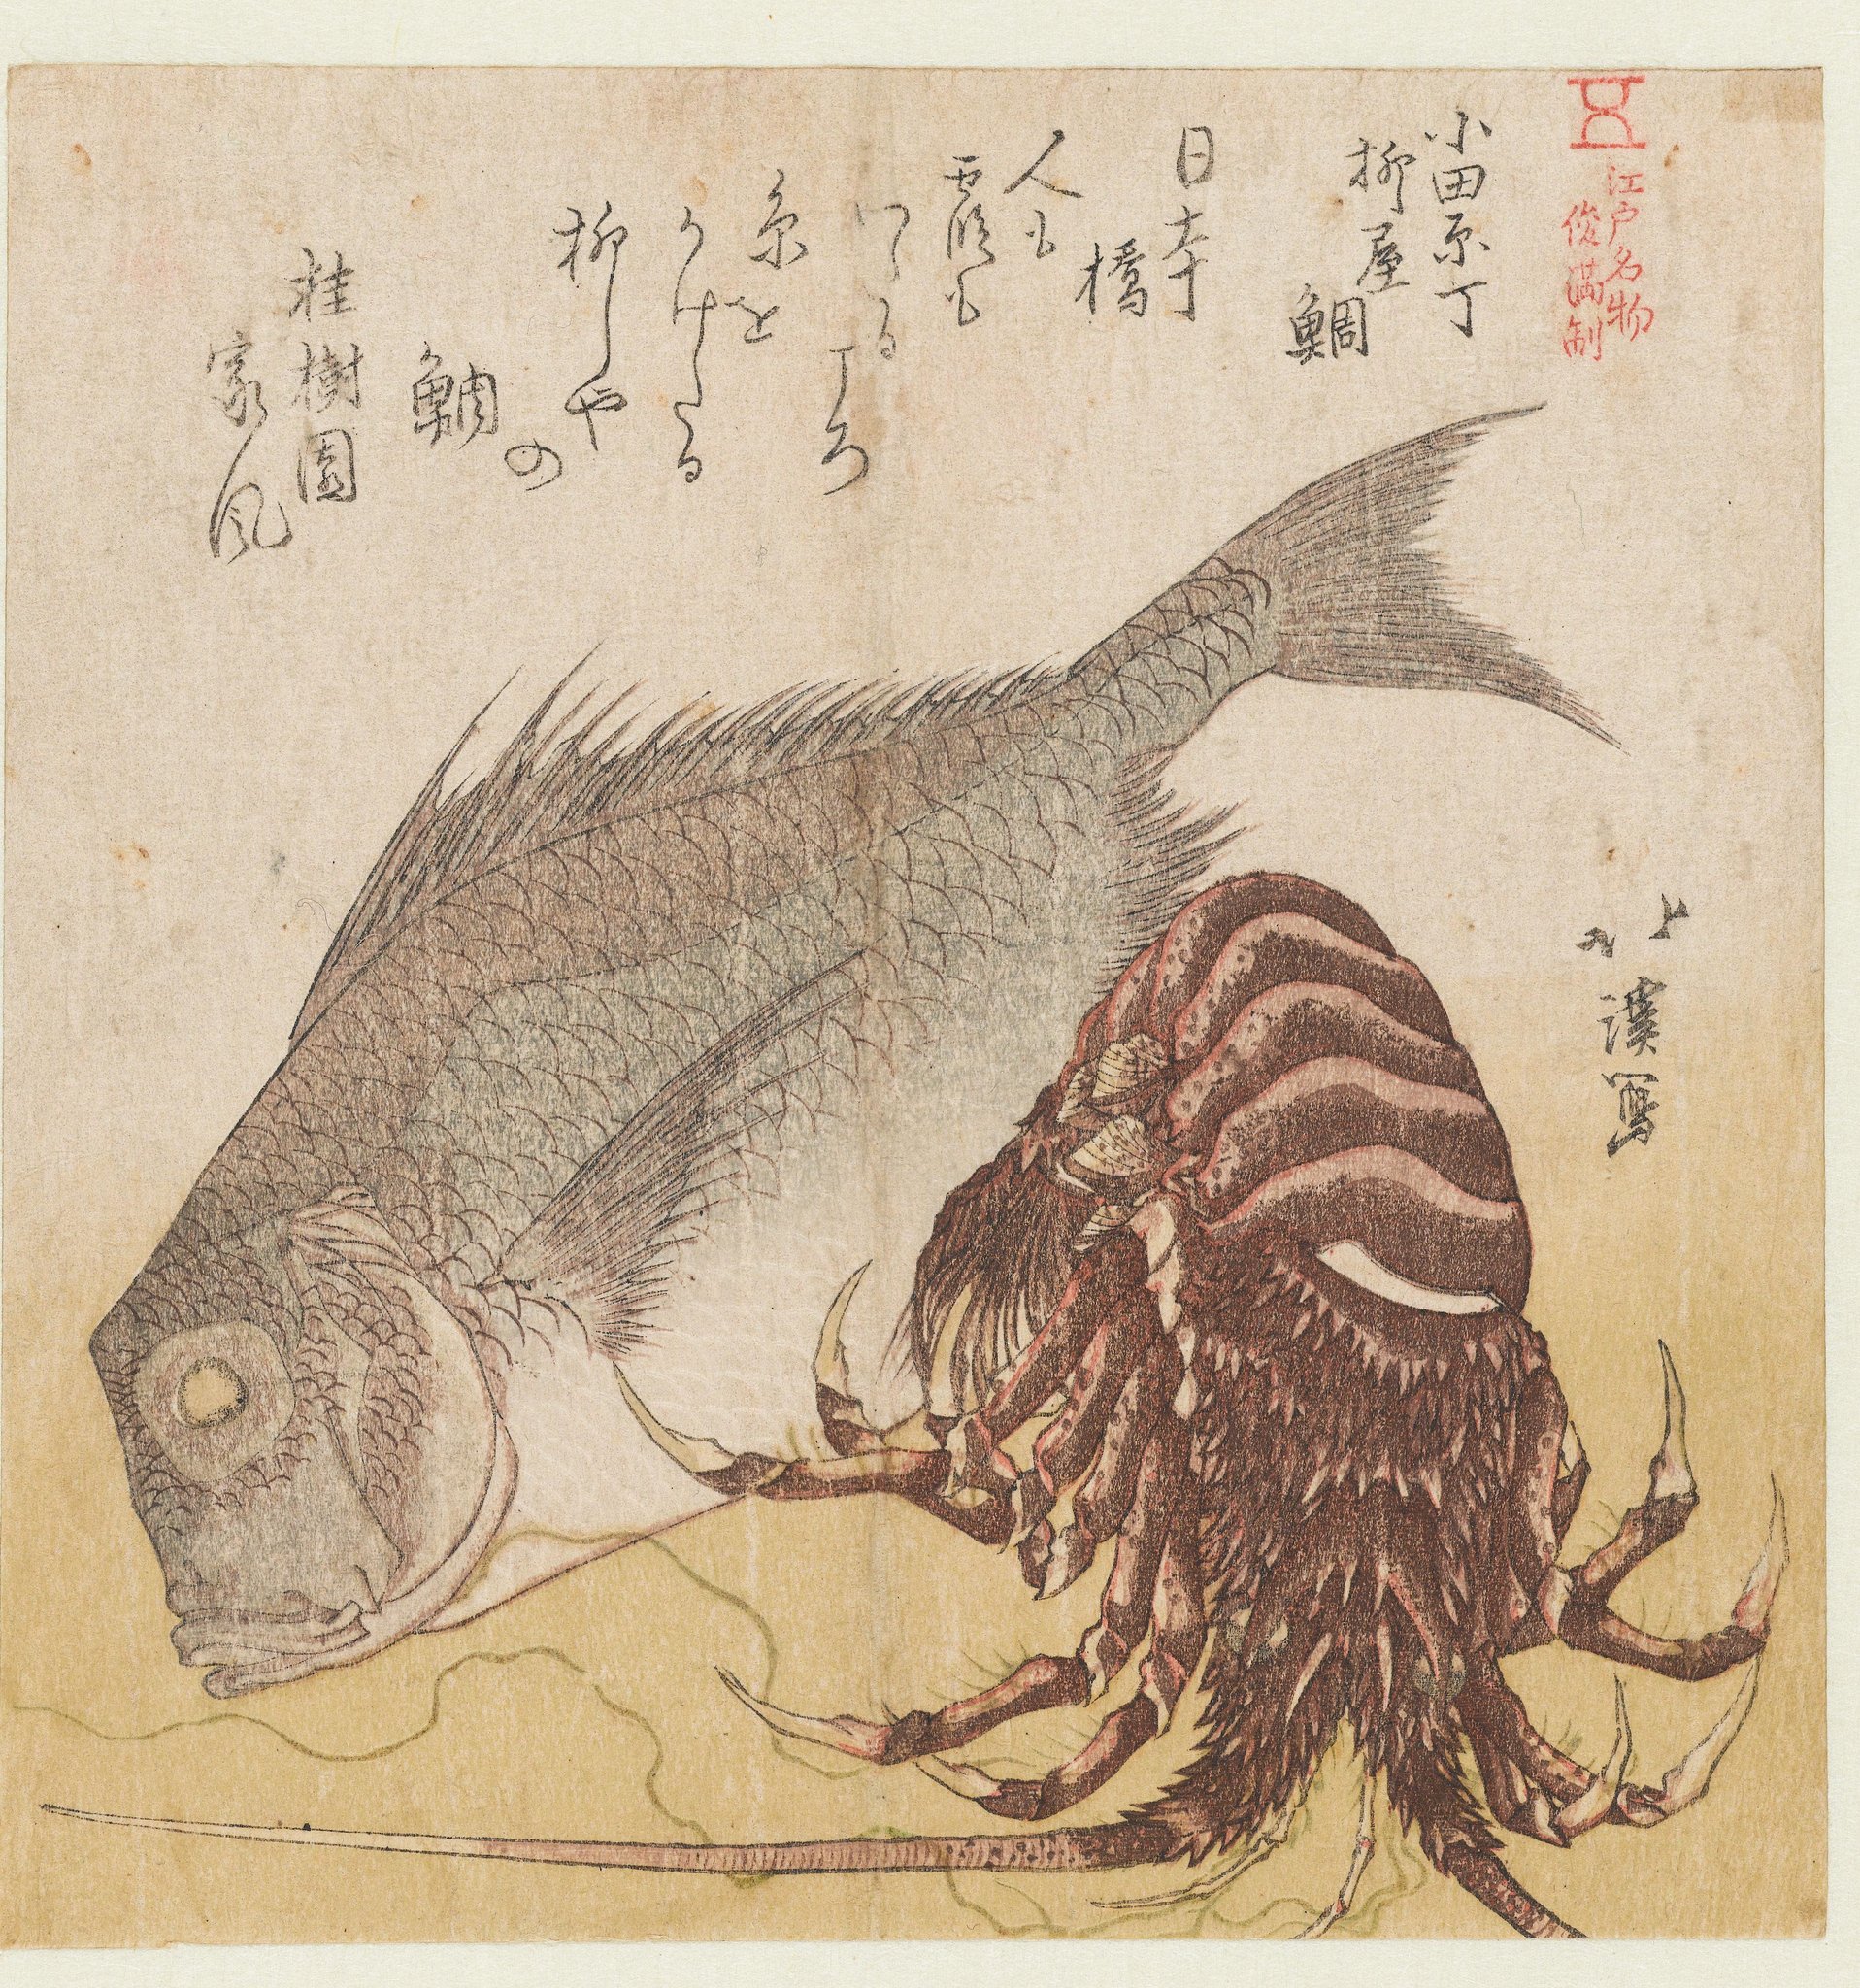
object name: surimono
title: De zeebaars van de Yanagiya in Odawarachô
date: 1819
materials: paper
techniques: blind stamped, woodcut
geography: japan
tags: crustaceans, bony fishes: sea-bream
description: Een surimono is een luxe uitgevoerde prent waarop beeld met één of meerdere gedichten gecombineerd is. Bij het drukken van een surimono werd vaak gebruik gemaakt van dikker papier, blinddruk en metaal pigmenten, zoals koper- en zilverpoeder. De prenten werden vaak in opdracht van dichters gemaakt en als exclusief geschenk aan vrienden en relaties gegeven.